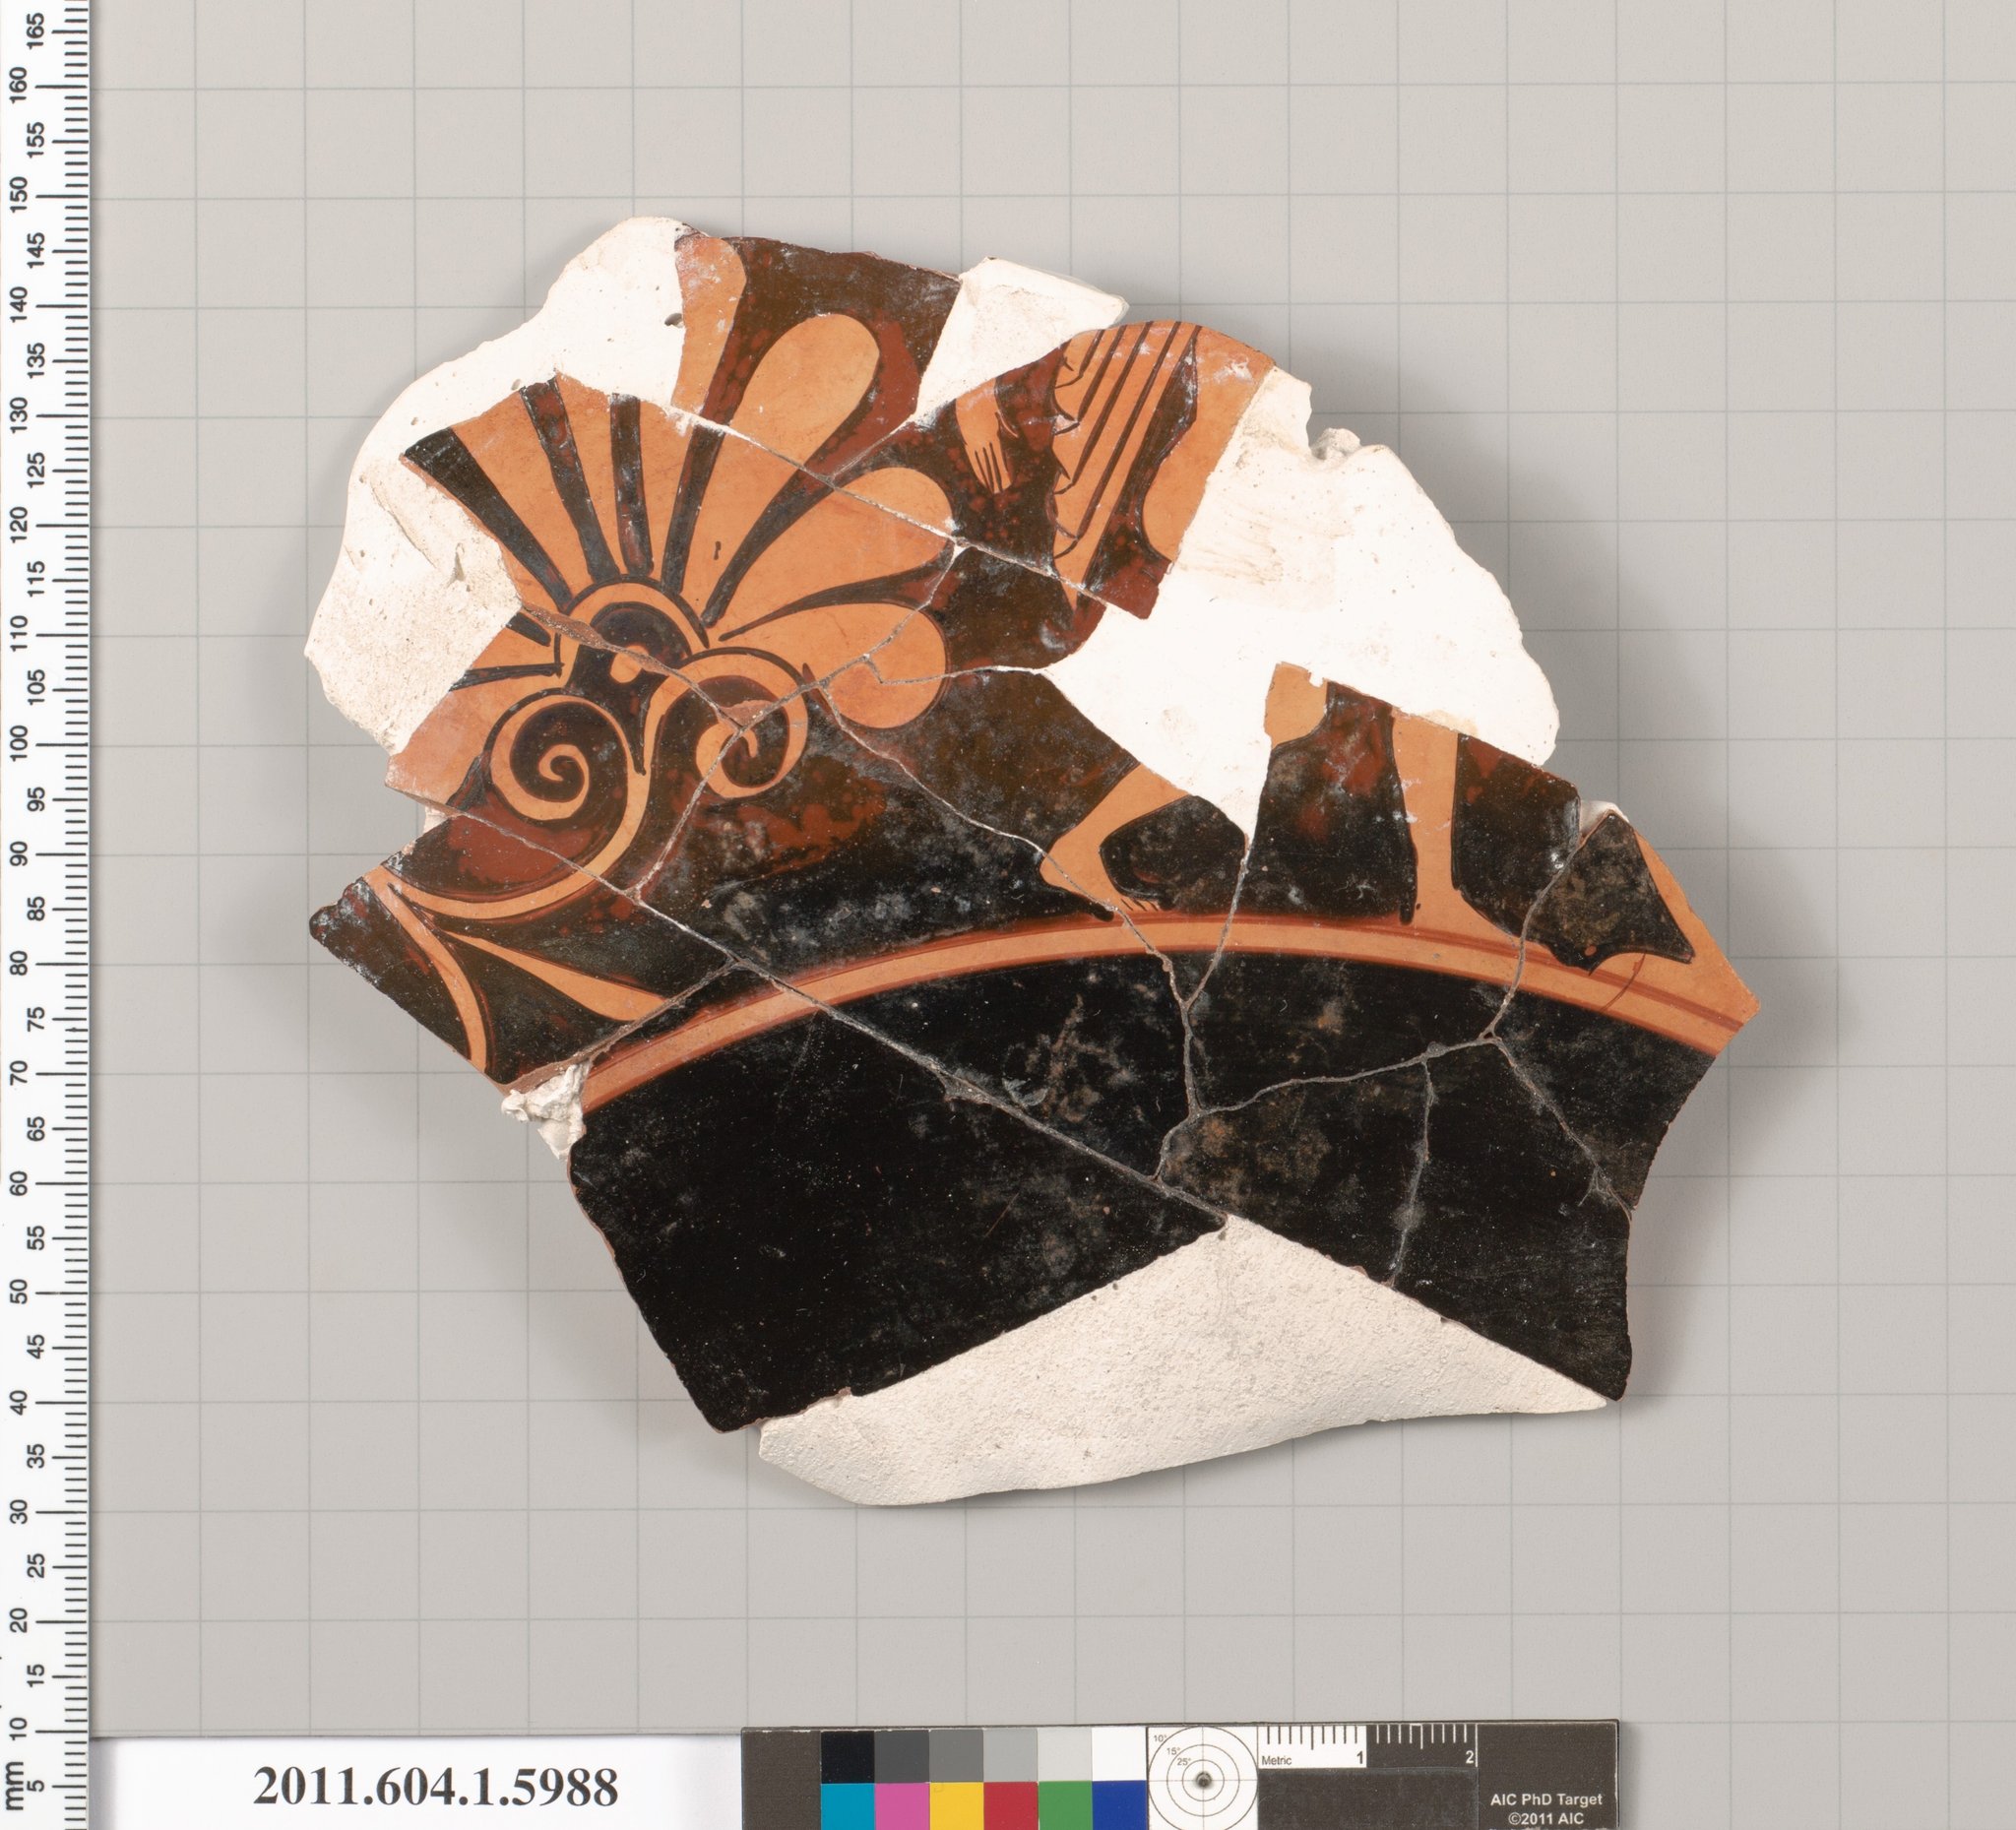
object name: kylix fragment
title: Terracotta fragment of a kylix (drinking cup)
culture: greek, attic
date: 510-500 BCE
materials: terracotta